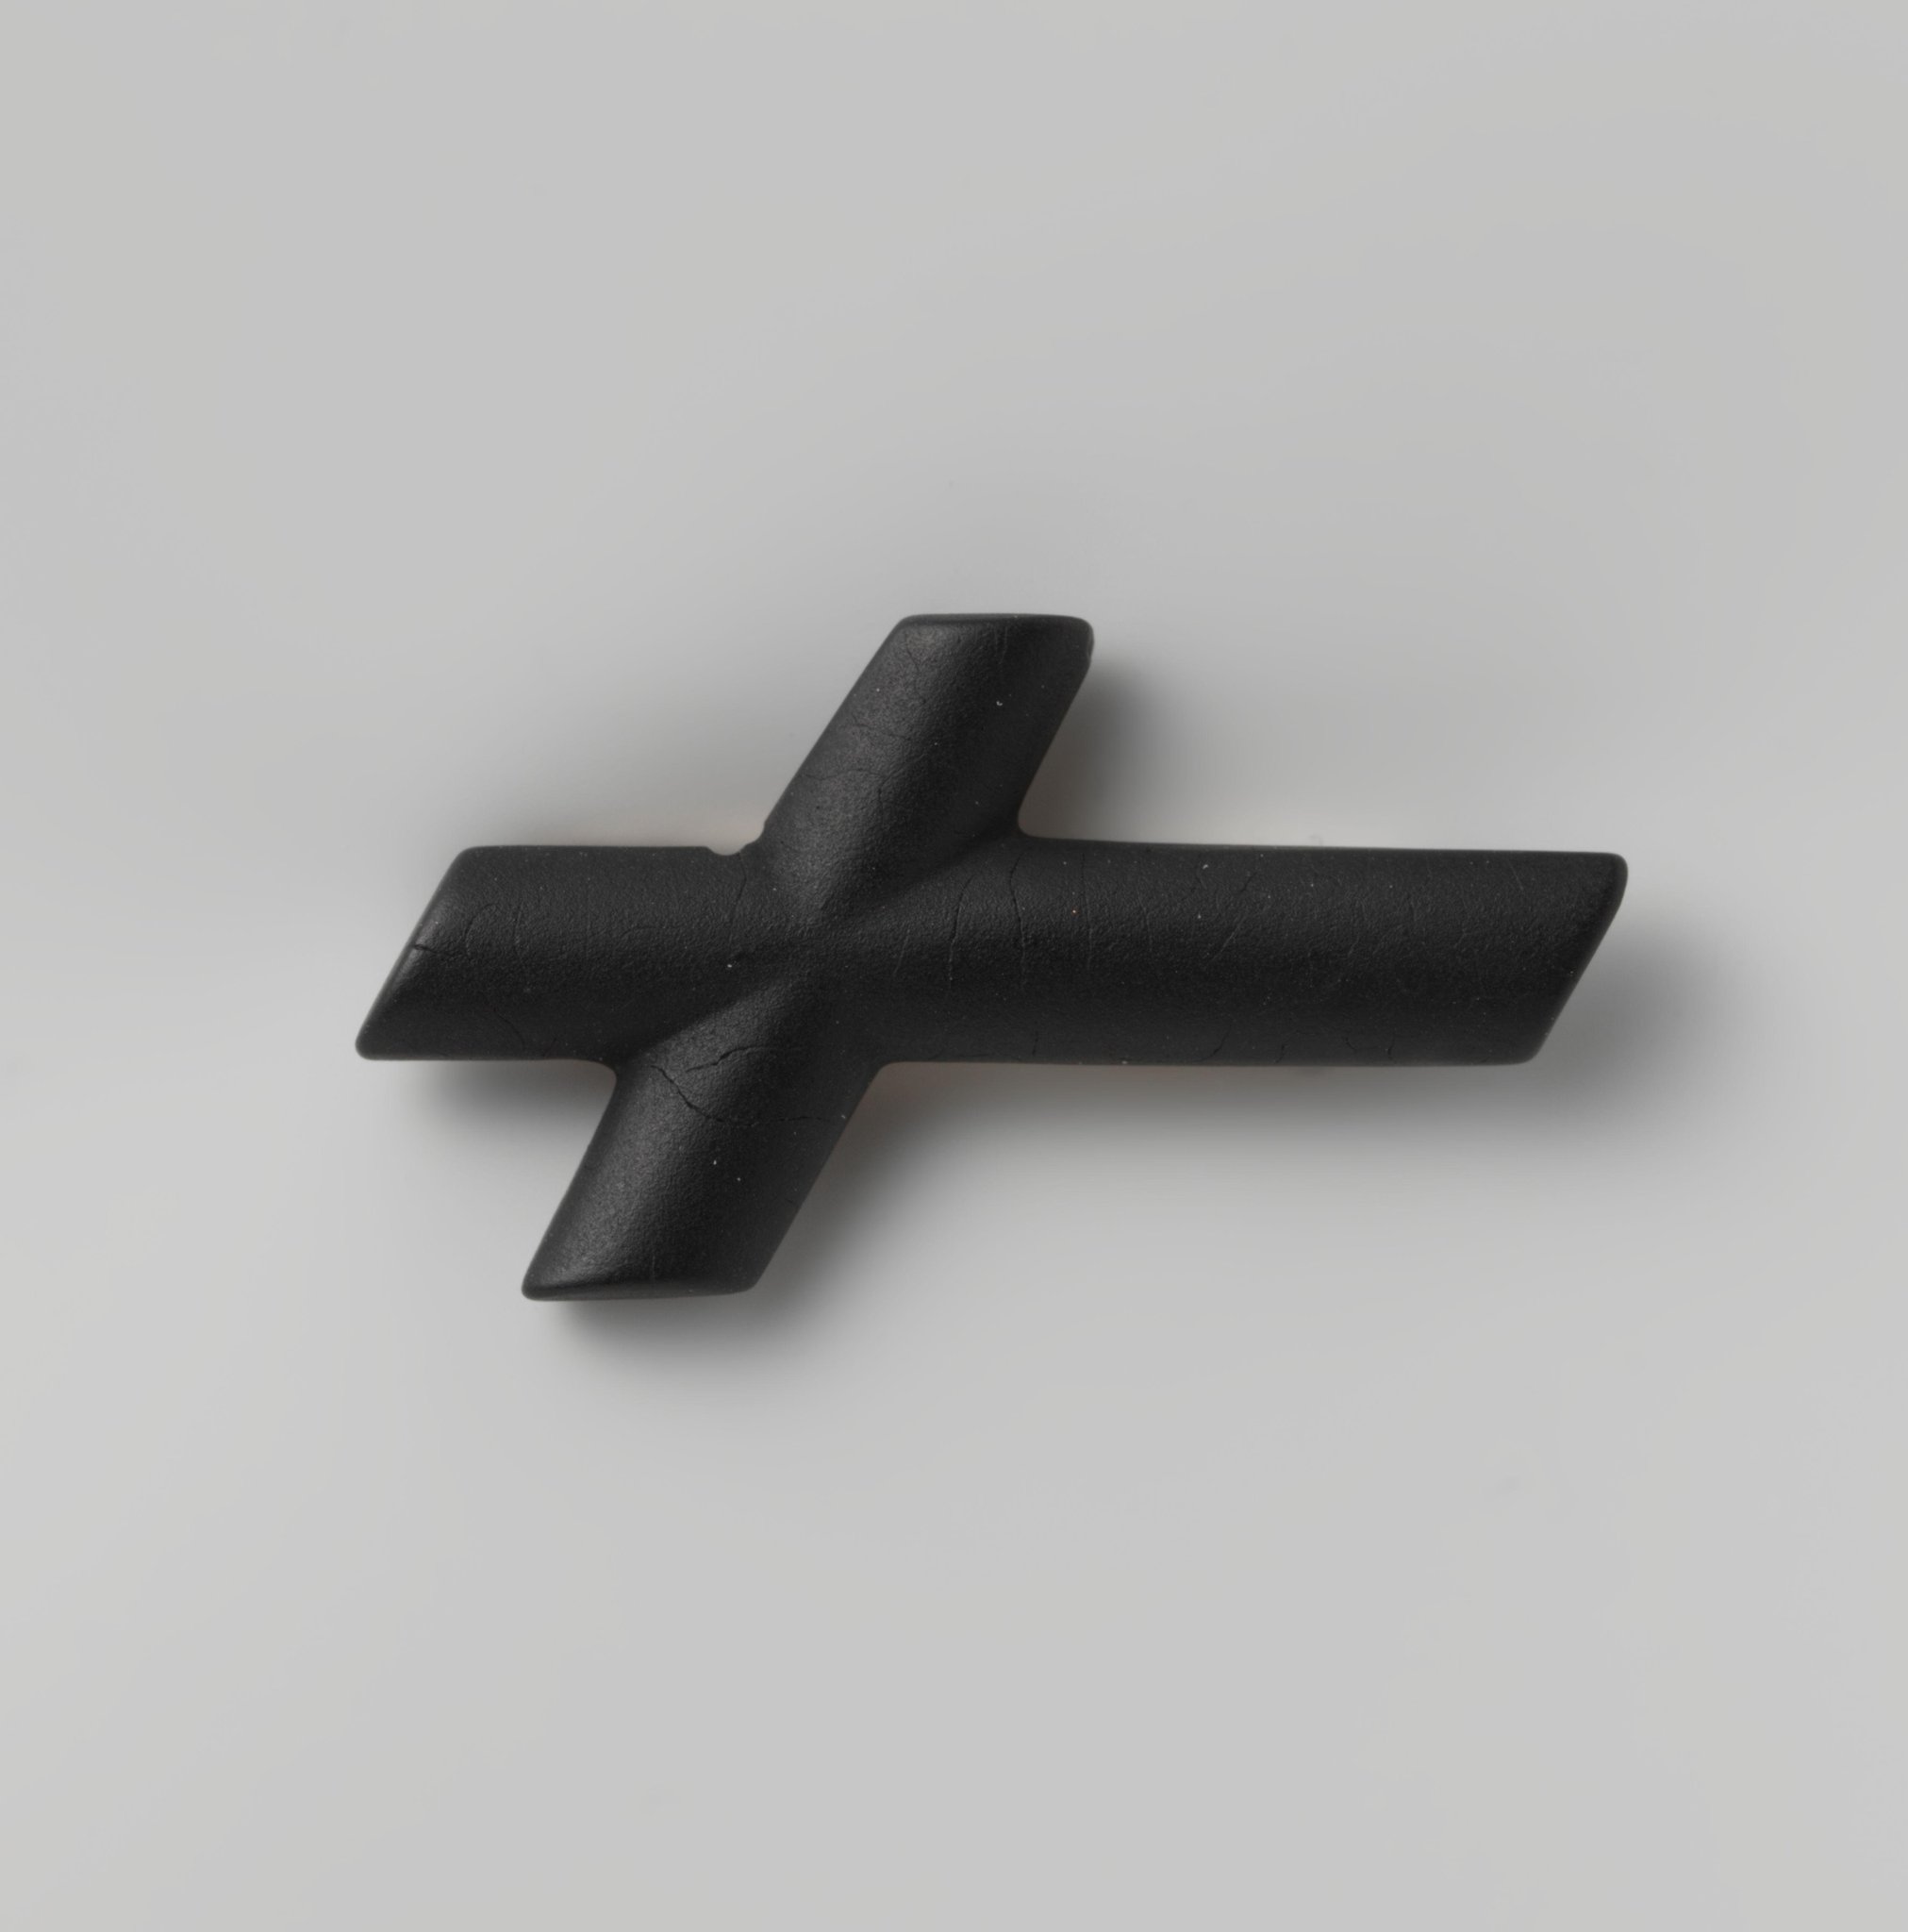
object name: mourning jewelry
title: Rouwbroche in de vorm van een kruis van glas en zilver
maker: Anonymous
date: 1880-1900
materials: glass, silver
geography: schoonhoven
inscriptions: alloy mark: ‘Z2’, alloy mark: ‘oud zwaard’, import mark: ‘G+F’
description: Rouwbroche in de vorm van een kruis van zwart glas op een brochering met haaksluiting van zilver.